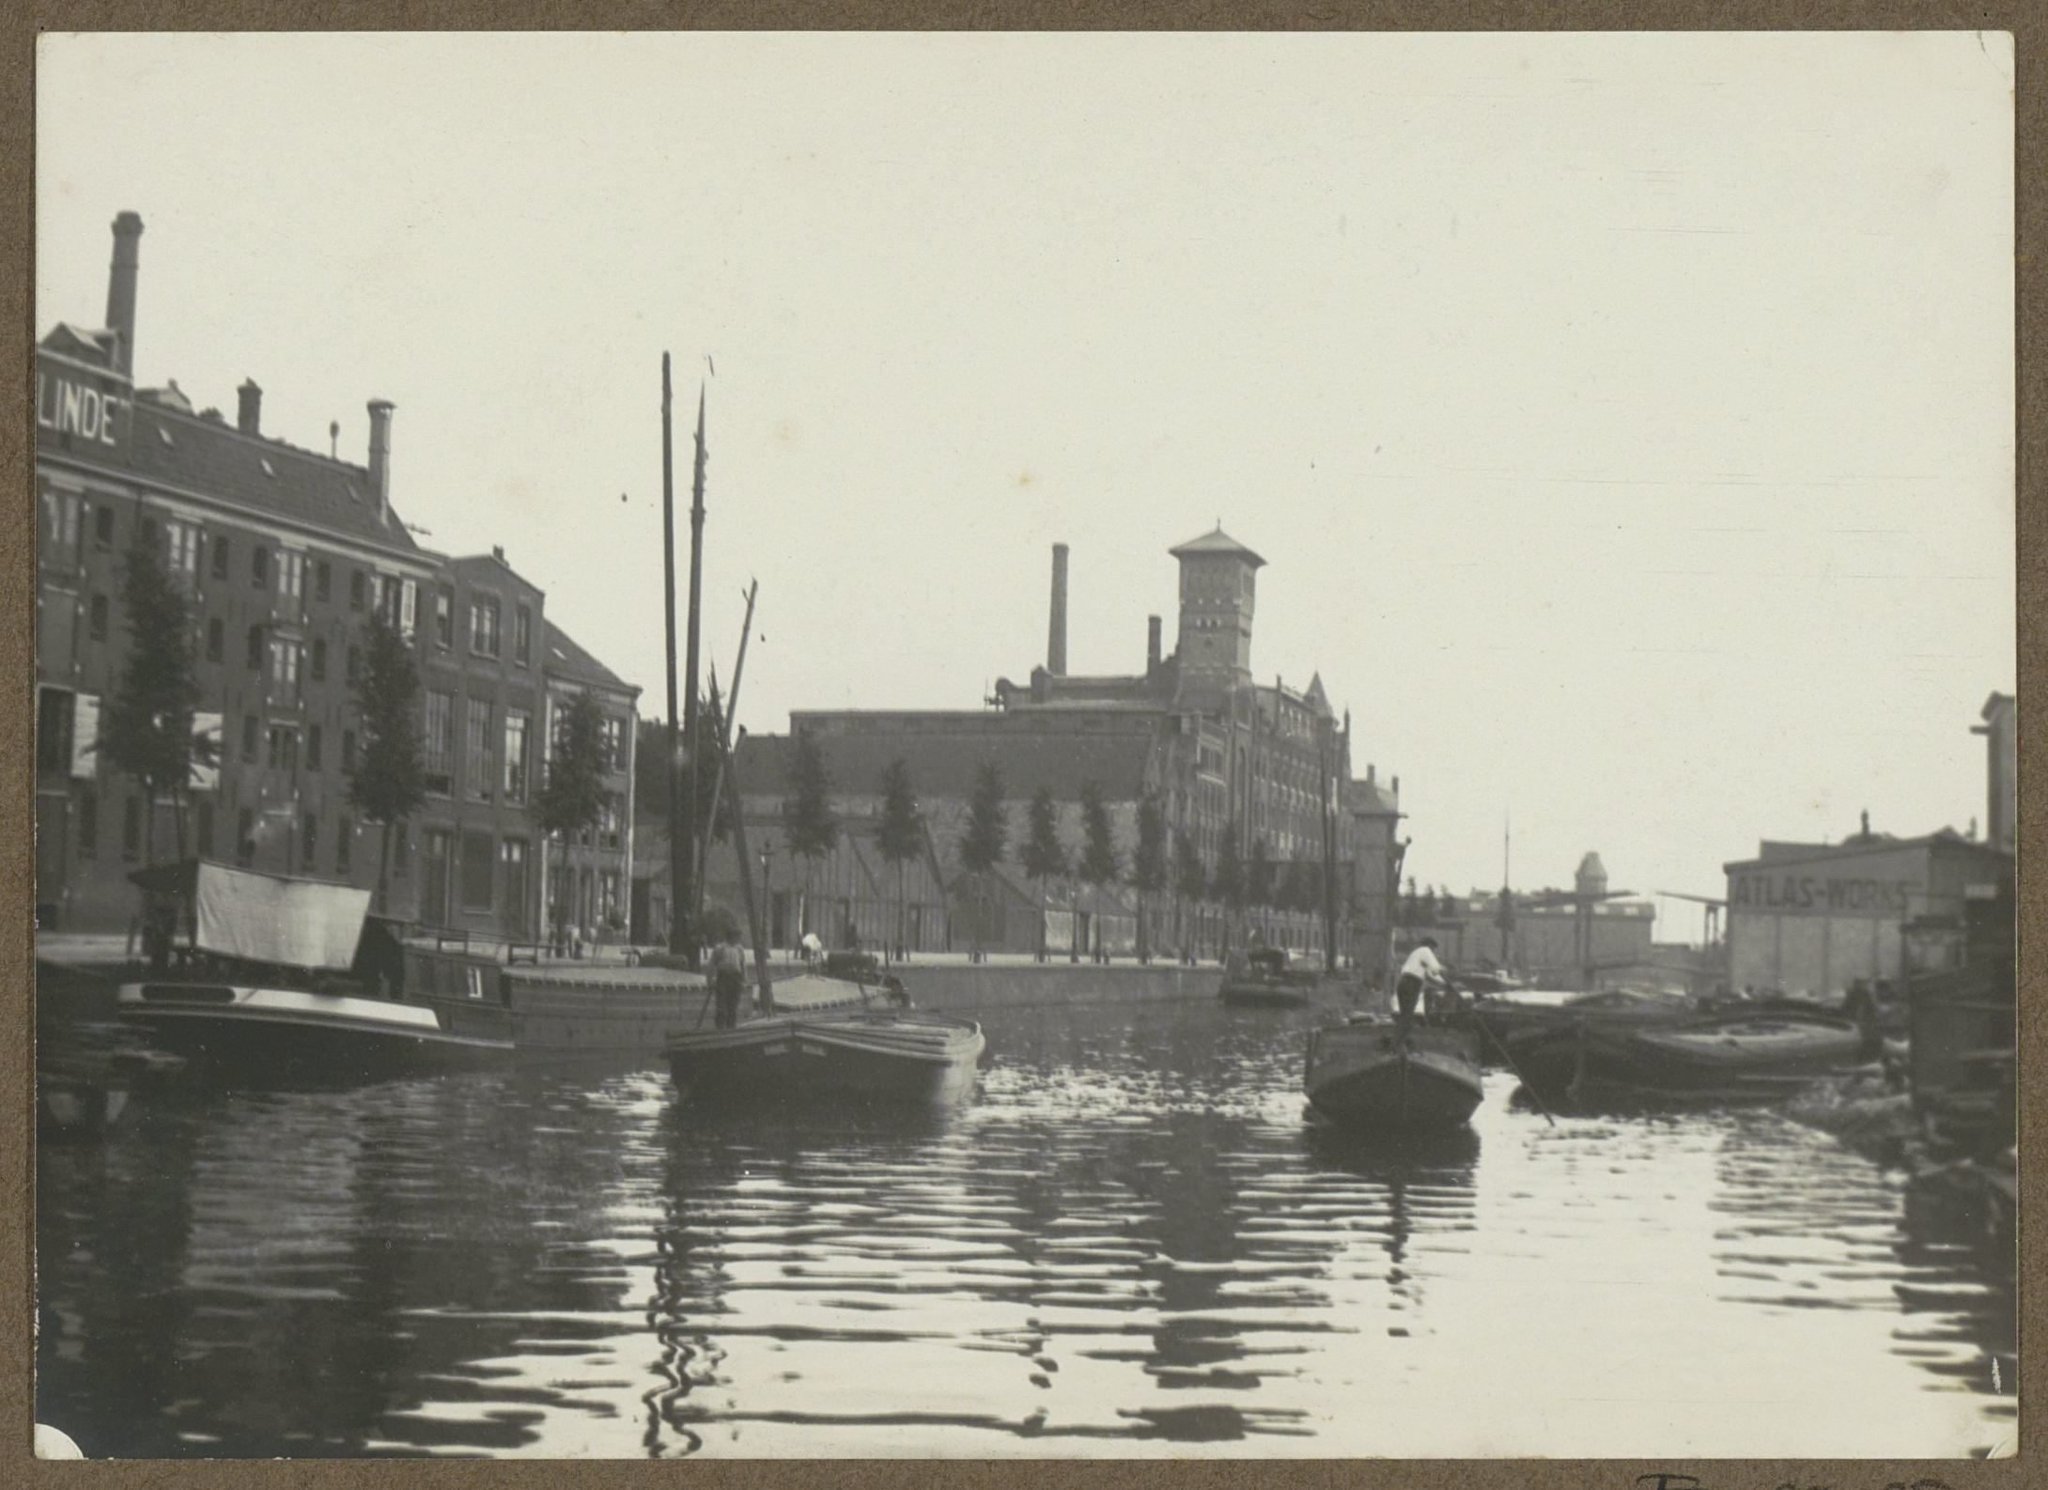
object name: photograph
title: Gezicht op de Zoutkeetsgracht te Amsterdam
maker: Anonymous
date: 1910-1930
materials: paper, photographic support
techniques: gelatin silver print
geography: amsterdam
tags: canal, amsterdam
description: Onderdeel van Album met foto's van Amsterdam en omgeving.